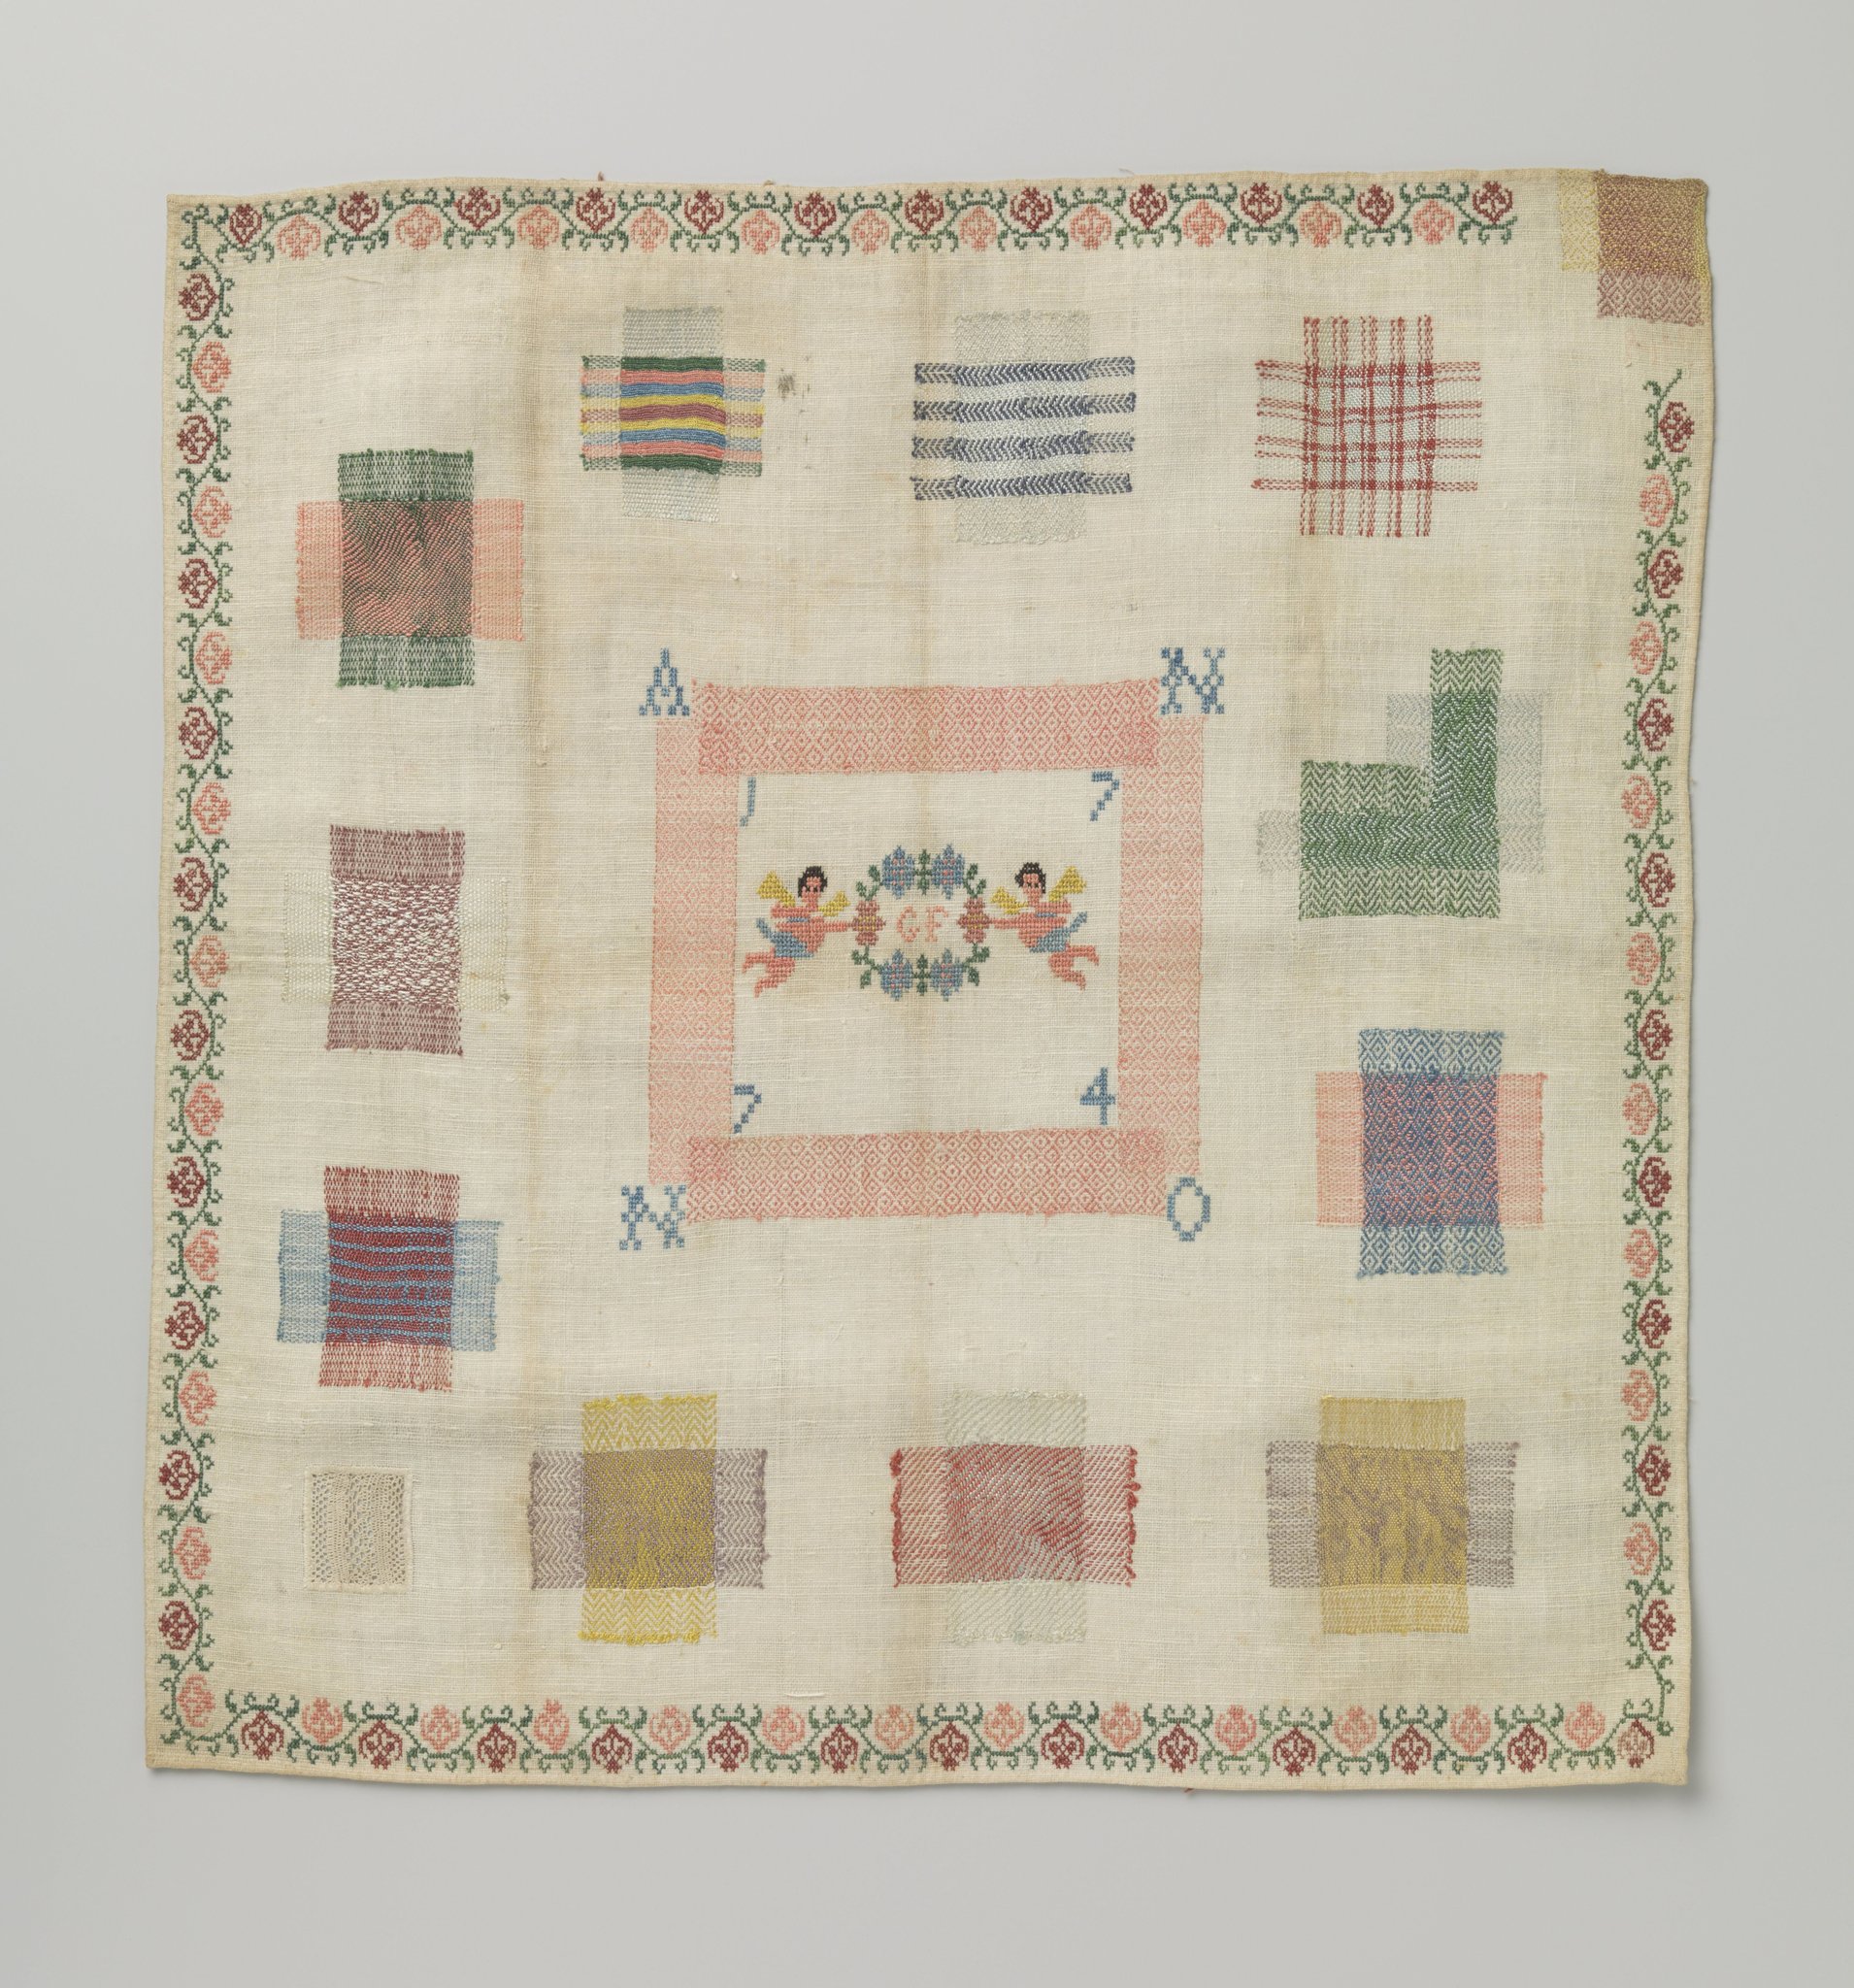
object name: stoplap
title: Stoplap van veelkleurige zijde en linnen op katoenen mousseline.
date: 1774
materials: cotton, linen, silk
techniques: embroidered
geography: netherlands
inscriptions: date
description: Stoplap met borduurwerk. Het borduurwerk heeft het jaartal ANNO 1774, de initialen GF in een krans met beschermengelen en een bloemenrand langs de zoom.